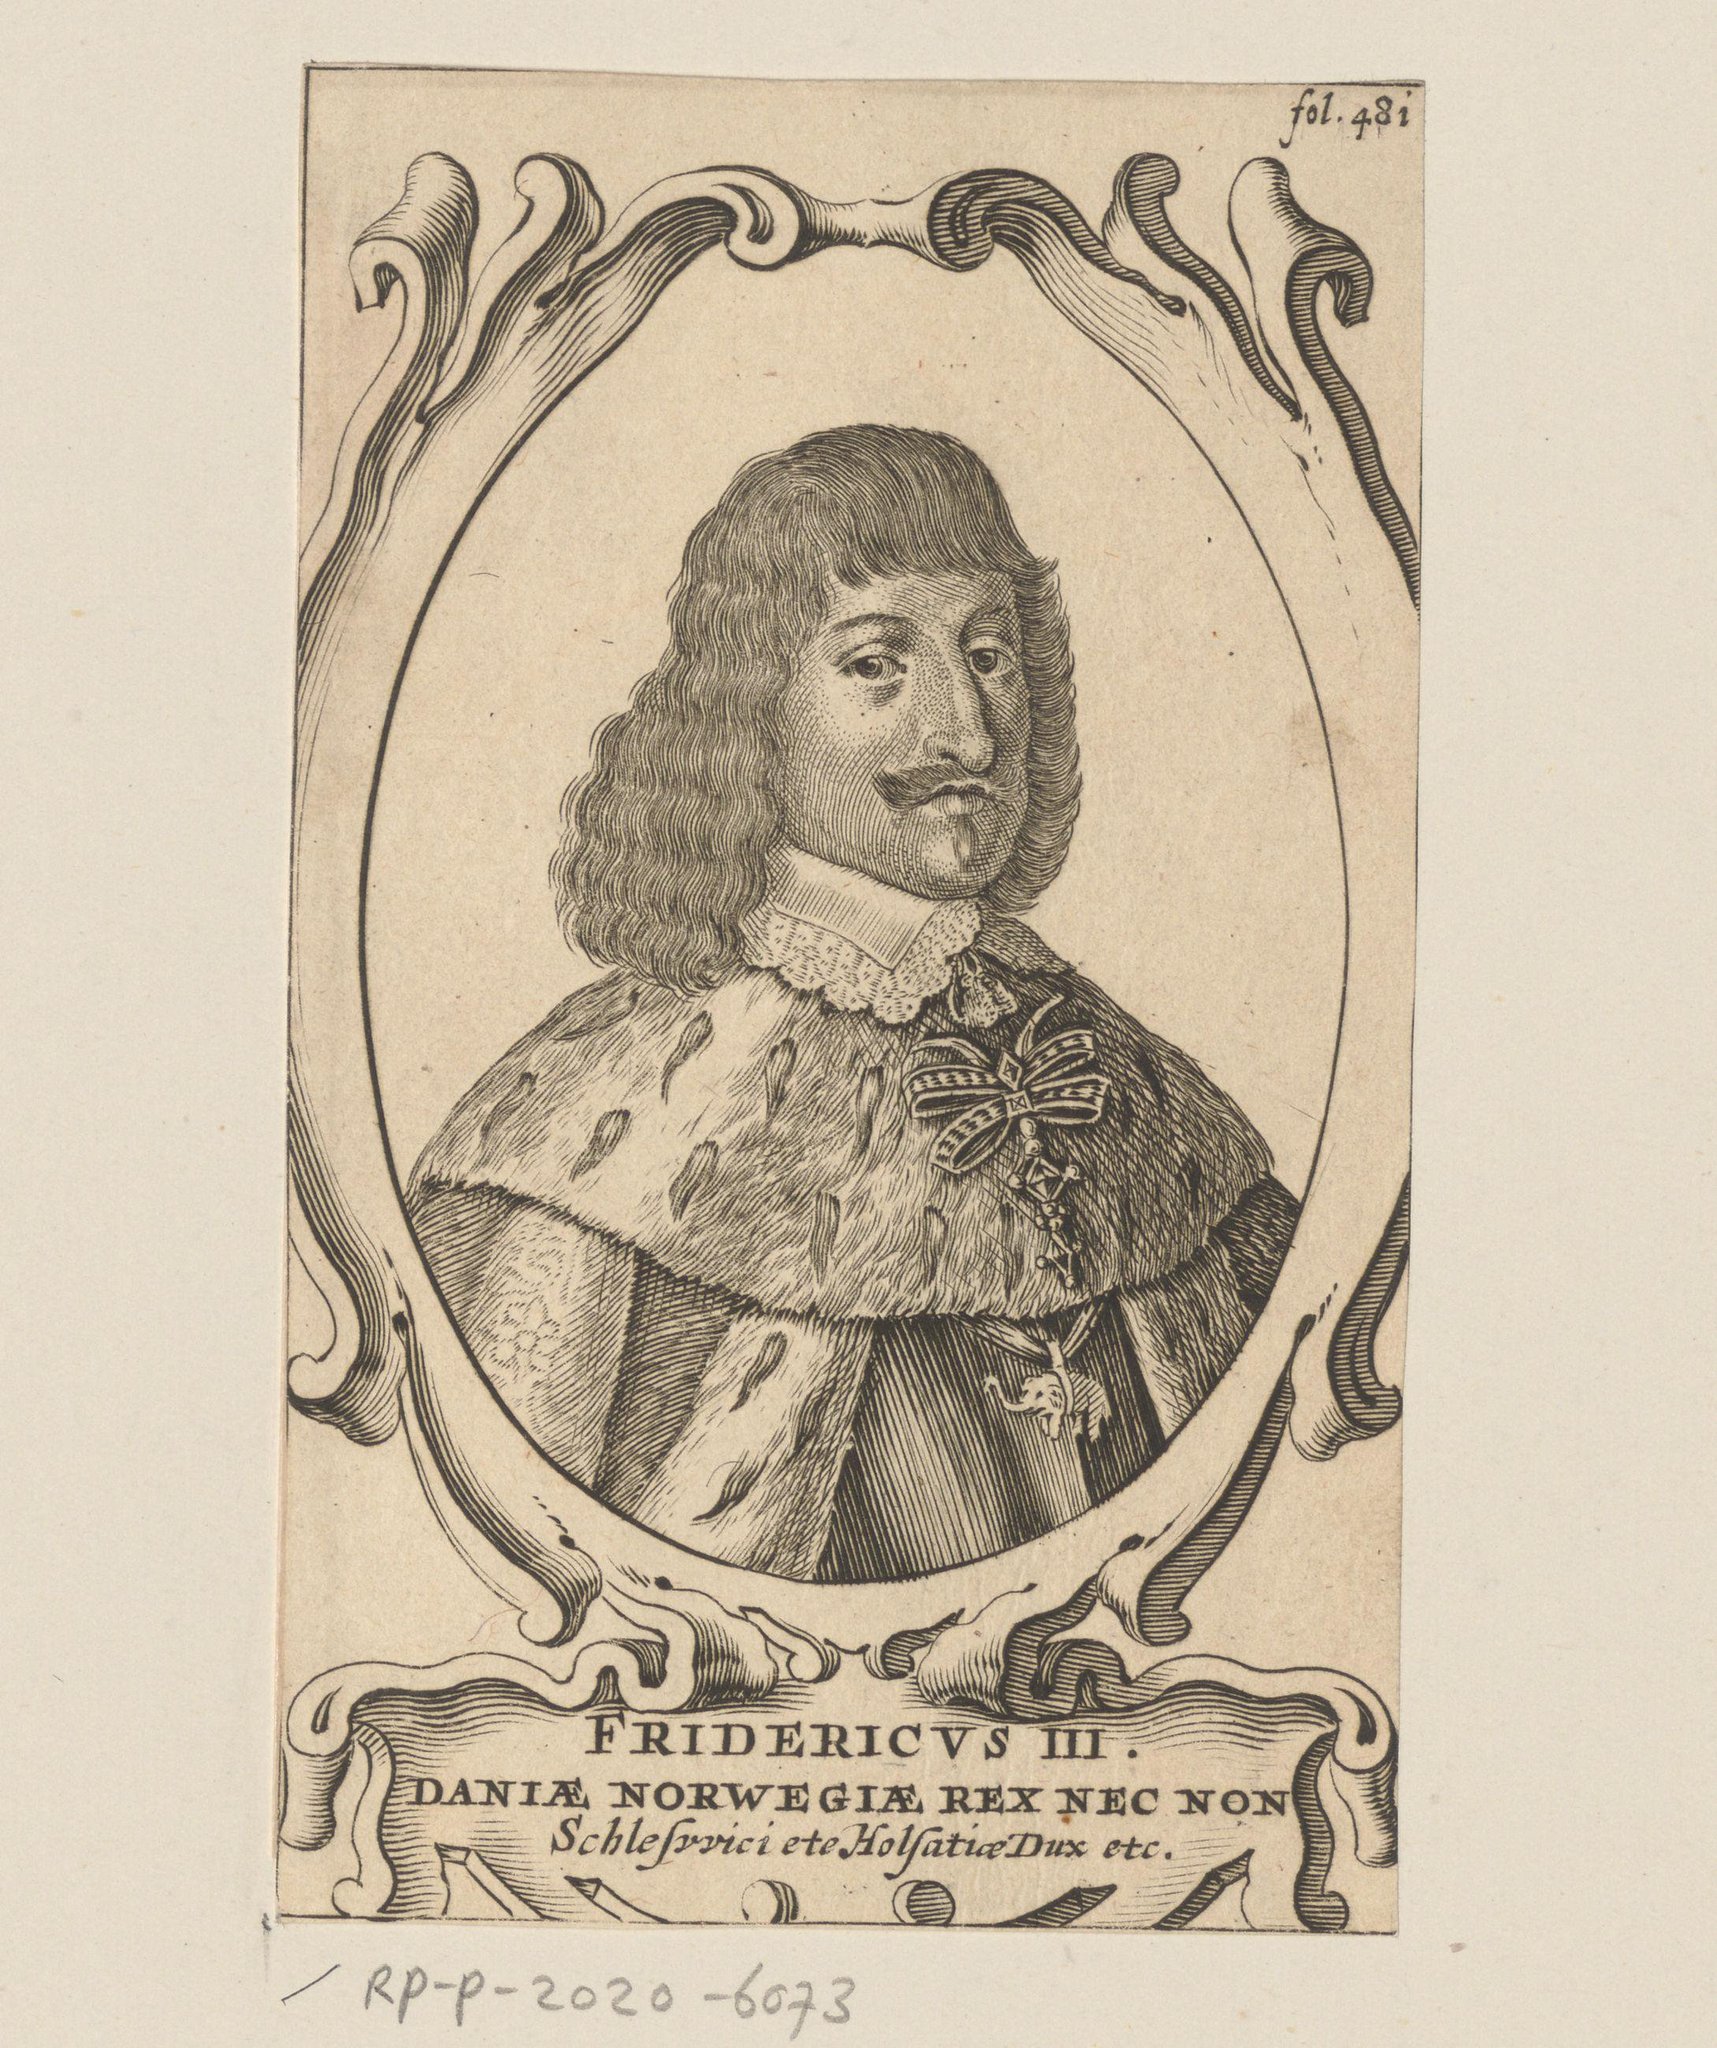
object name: book illustration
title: Portret van Frederik III van Denemarken en Noorwegen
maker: Anonymous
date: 1656-1666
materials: paper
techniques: engraving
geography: northern netherlands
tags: copenhagen (city), frederik iii (koning van denemarken en noorwegen), rocaille ornament, historical persons, king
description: Prent waarschijnlijk uit: Brachelius, Johannes Adolphus. Historia nostri temporis, dat is geschiedenis onses tijts (…). Rotterdam: Andries van Hoogenhuysen, 1656. Prent ook gebruikt in de 1659- en 1666-editie.